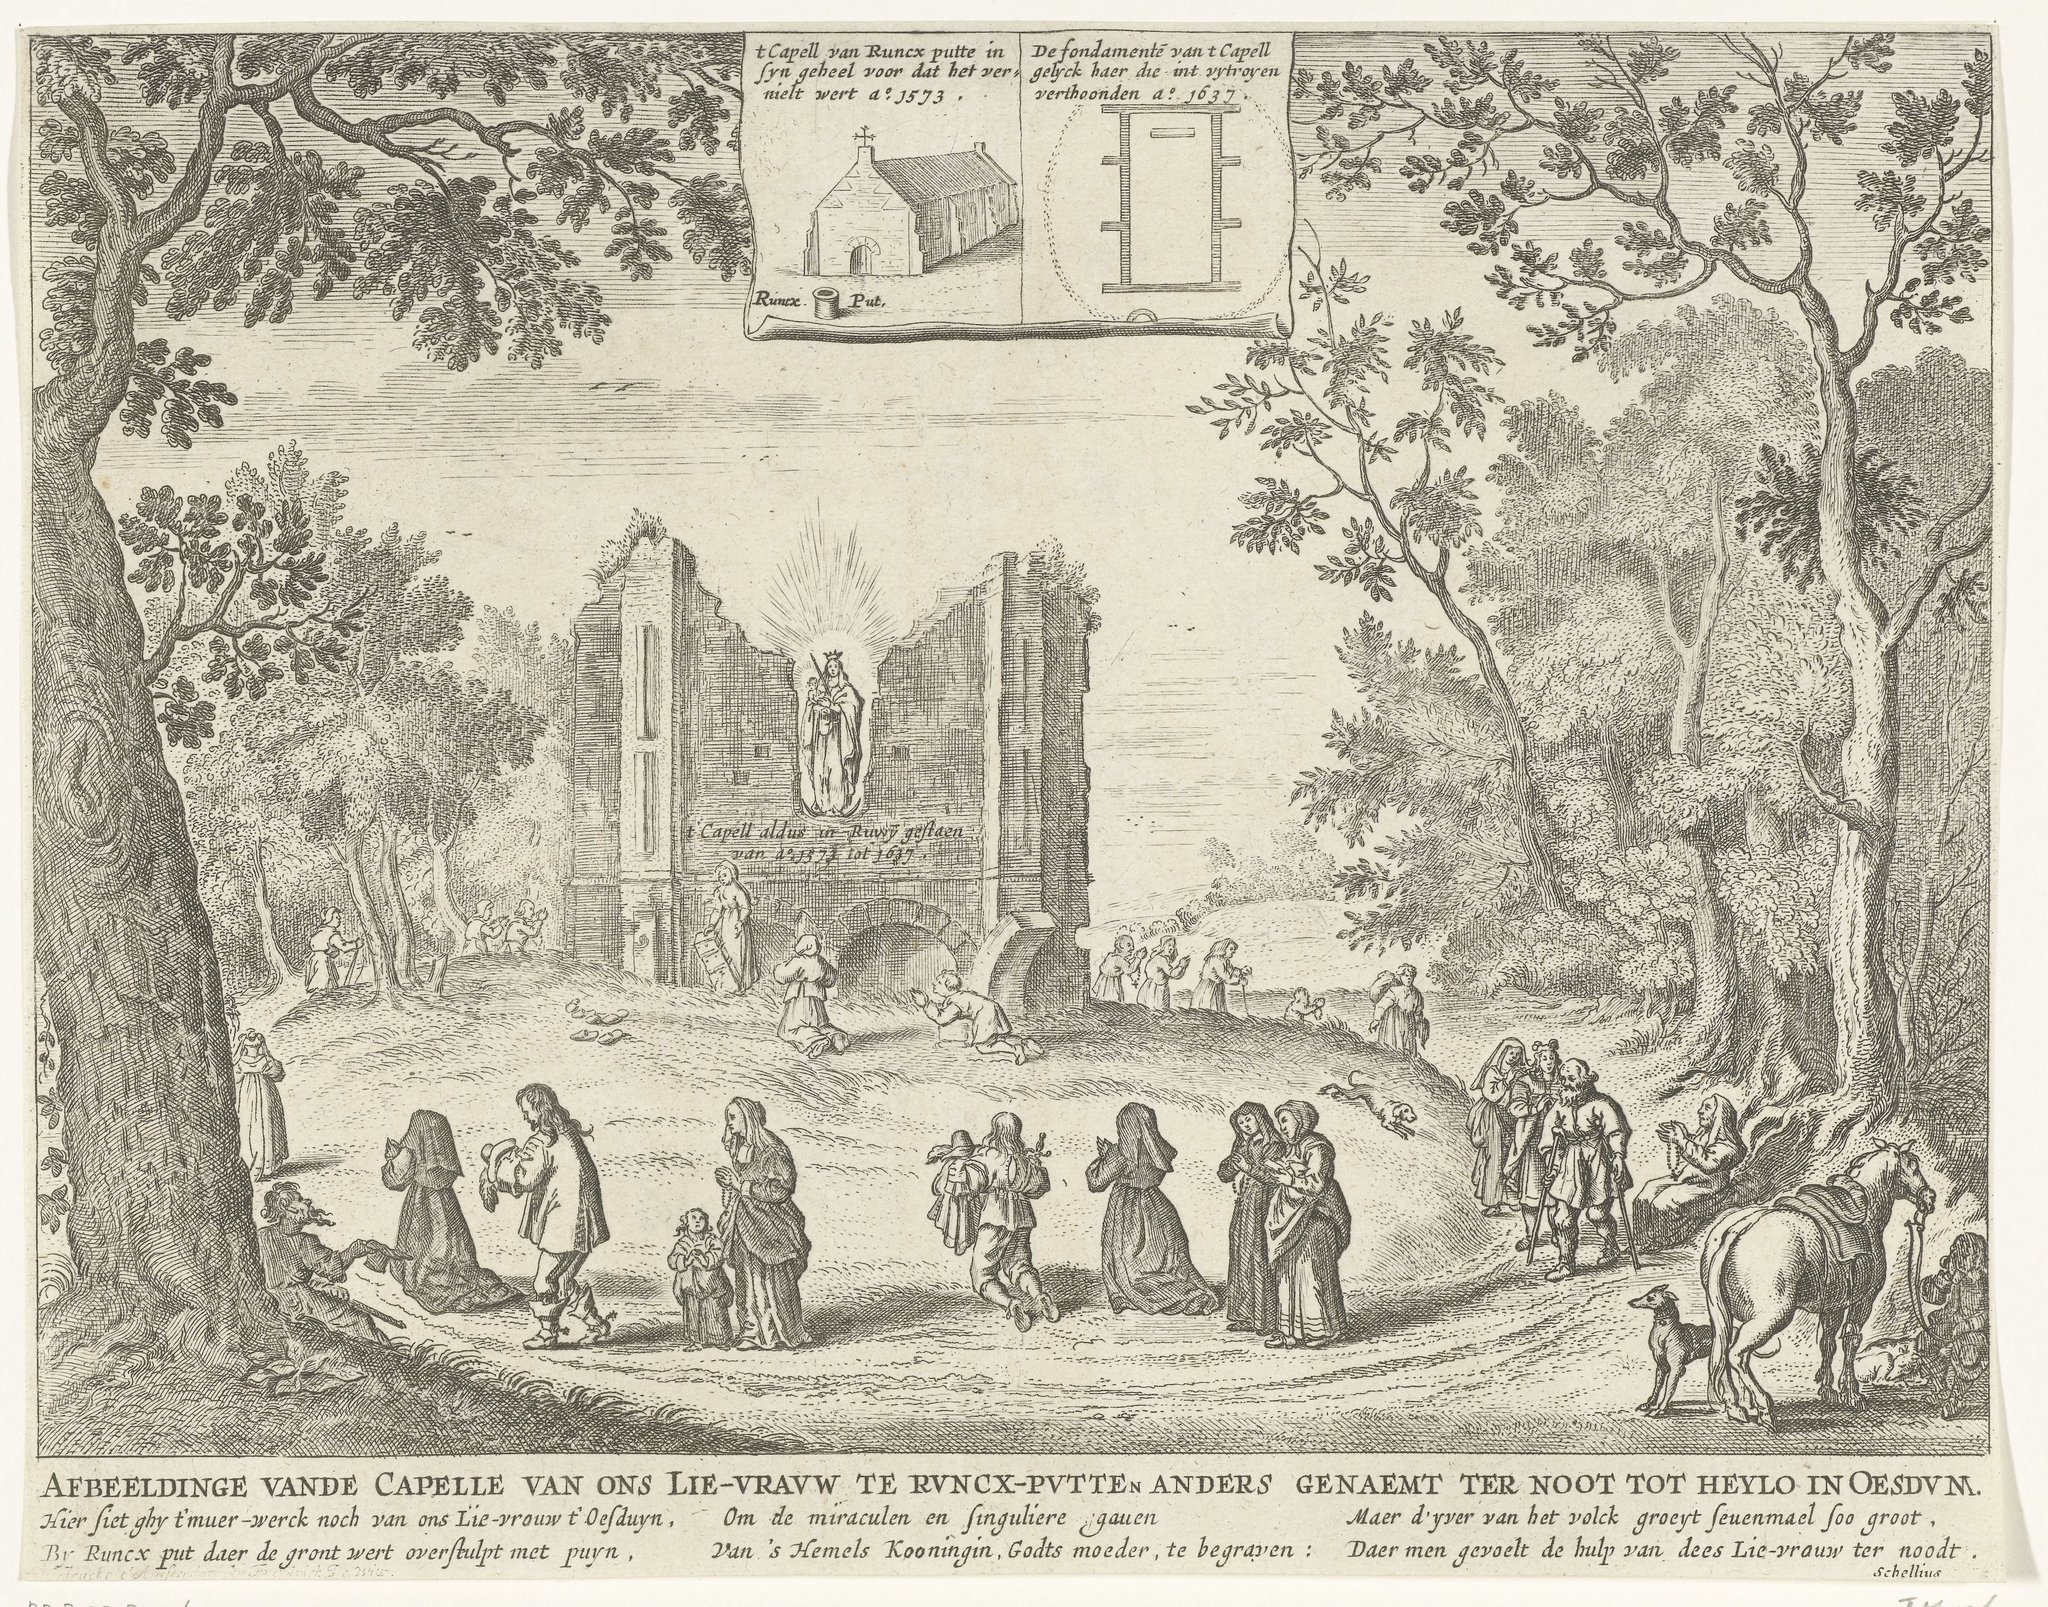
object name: print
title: Bedevaartgangers bij Onze Lieve Vrouwe ter Nood te Heiloo, 1637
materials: paper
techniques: engraving, etching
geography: amsterdam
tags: person with a physical disability, pilgrimage, pilgrim(s) under way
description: Het bedevaartsoord Onze Lieve Vrouwe ter Nood te Heiloo met de ruïne van de katholieke kapel, verwoest in 1573, en het Mariabeeld dat in 1637 in de ruïne is gevonden. Om de ruïne lopen bedevaartgangers. De kapel was in 1409 gebouwd naast een waterput, de Runxputte, die men als geneeskrachtig beschouwde. Bovenaan hangt een rol papier met een voorstelling van hoe de kapel er vóór de verwoesting uitzag en een plattegrond. In het onderschrift een vers van drie keer twee regels in het Nederlands.